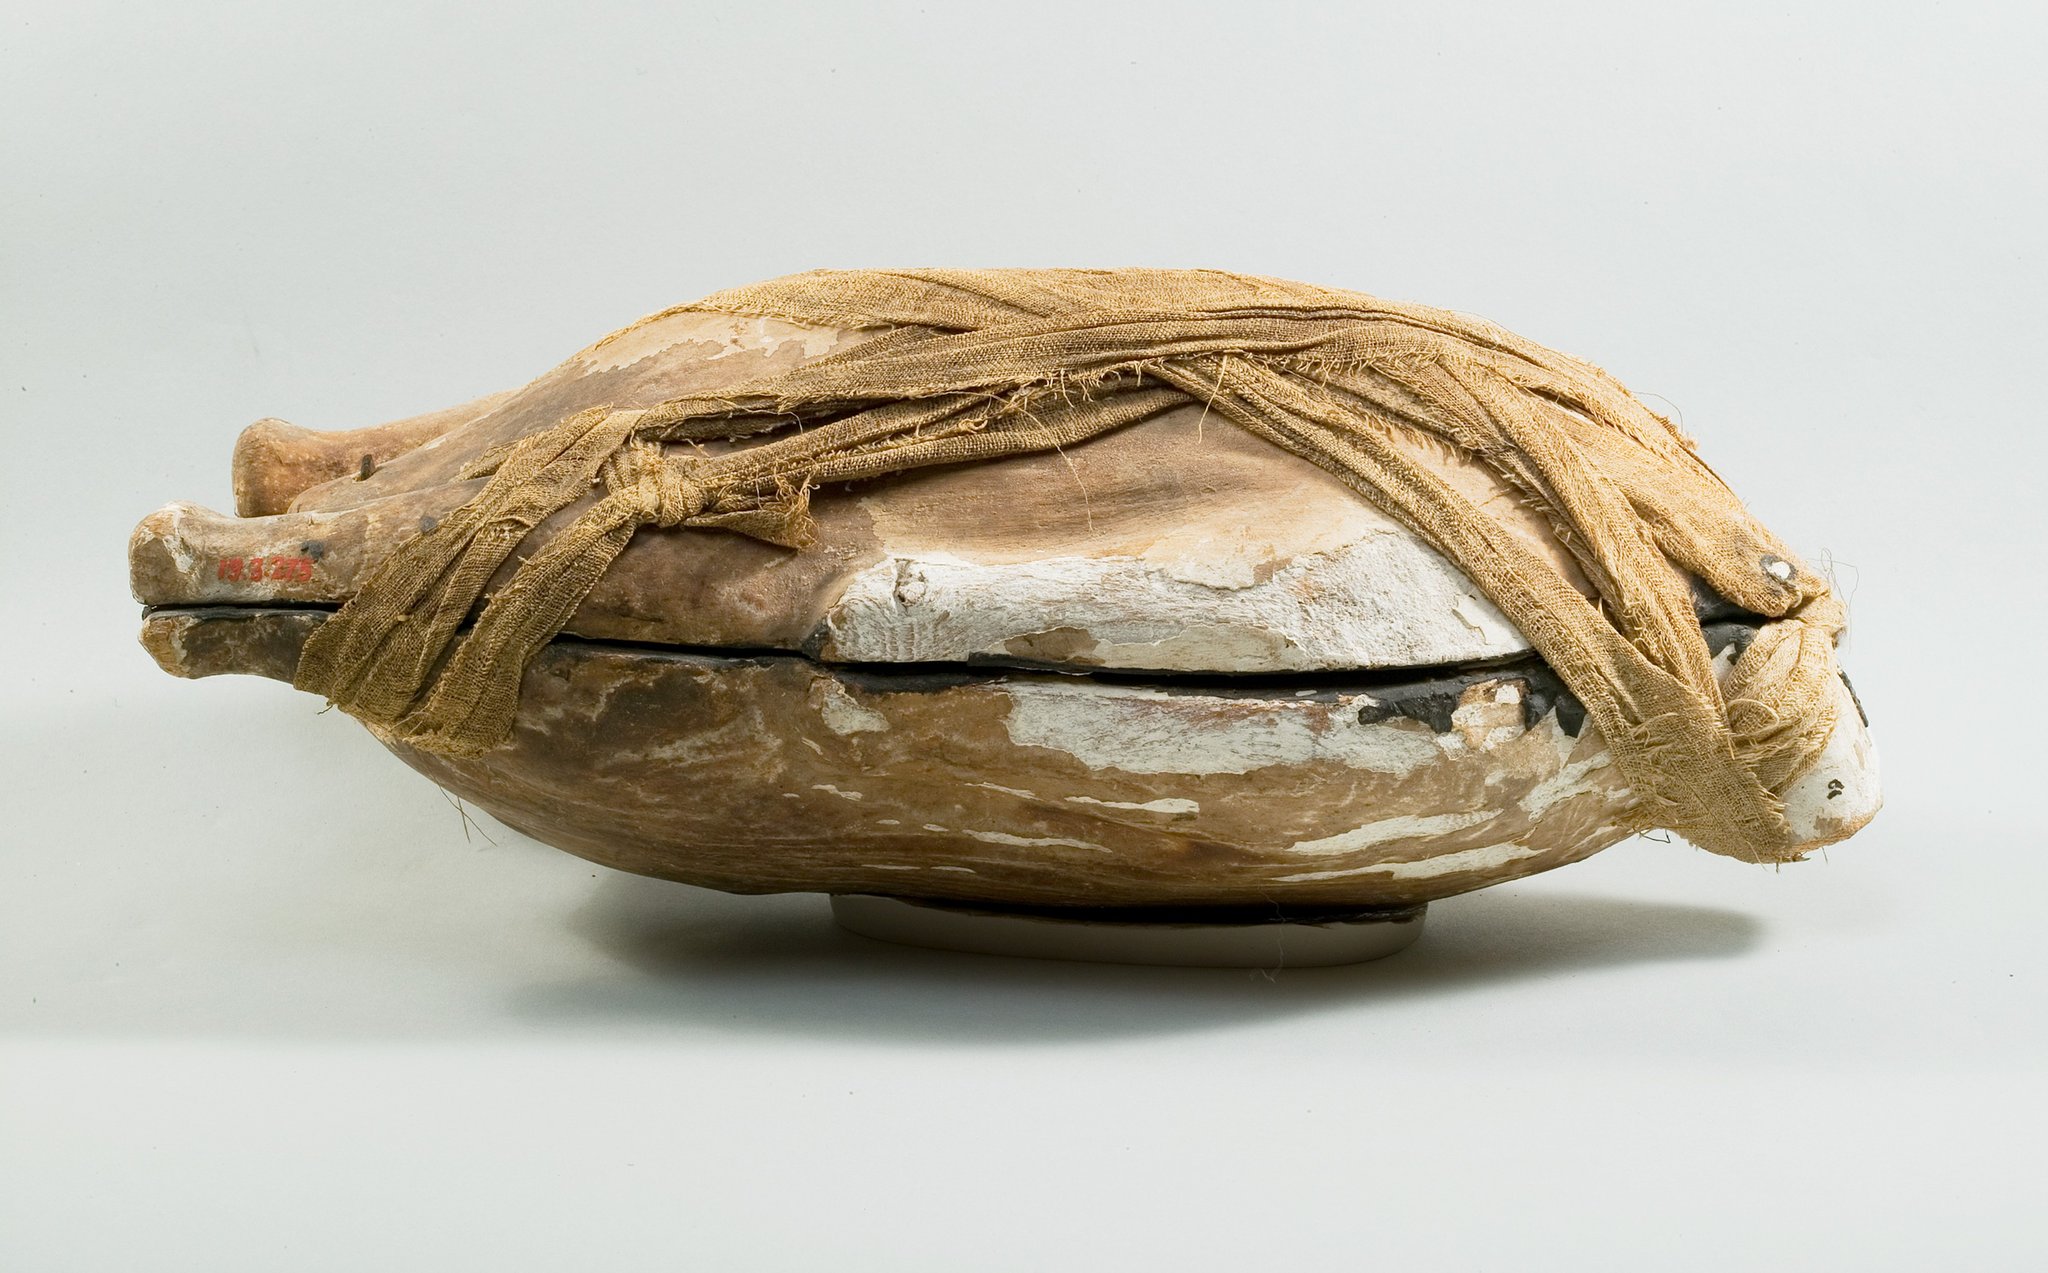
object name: food, case, bird, duck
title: Food Case Probably Containing a Preserved Duck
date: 1550-1479 BCE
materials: linen, plaster, wood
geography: egypt